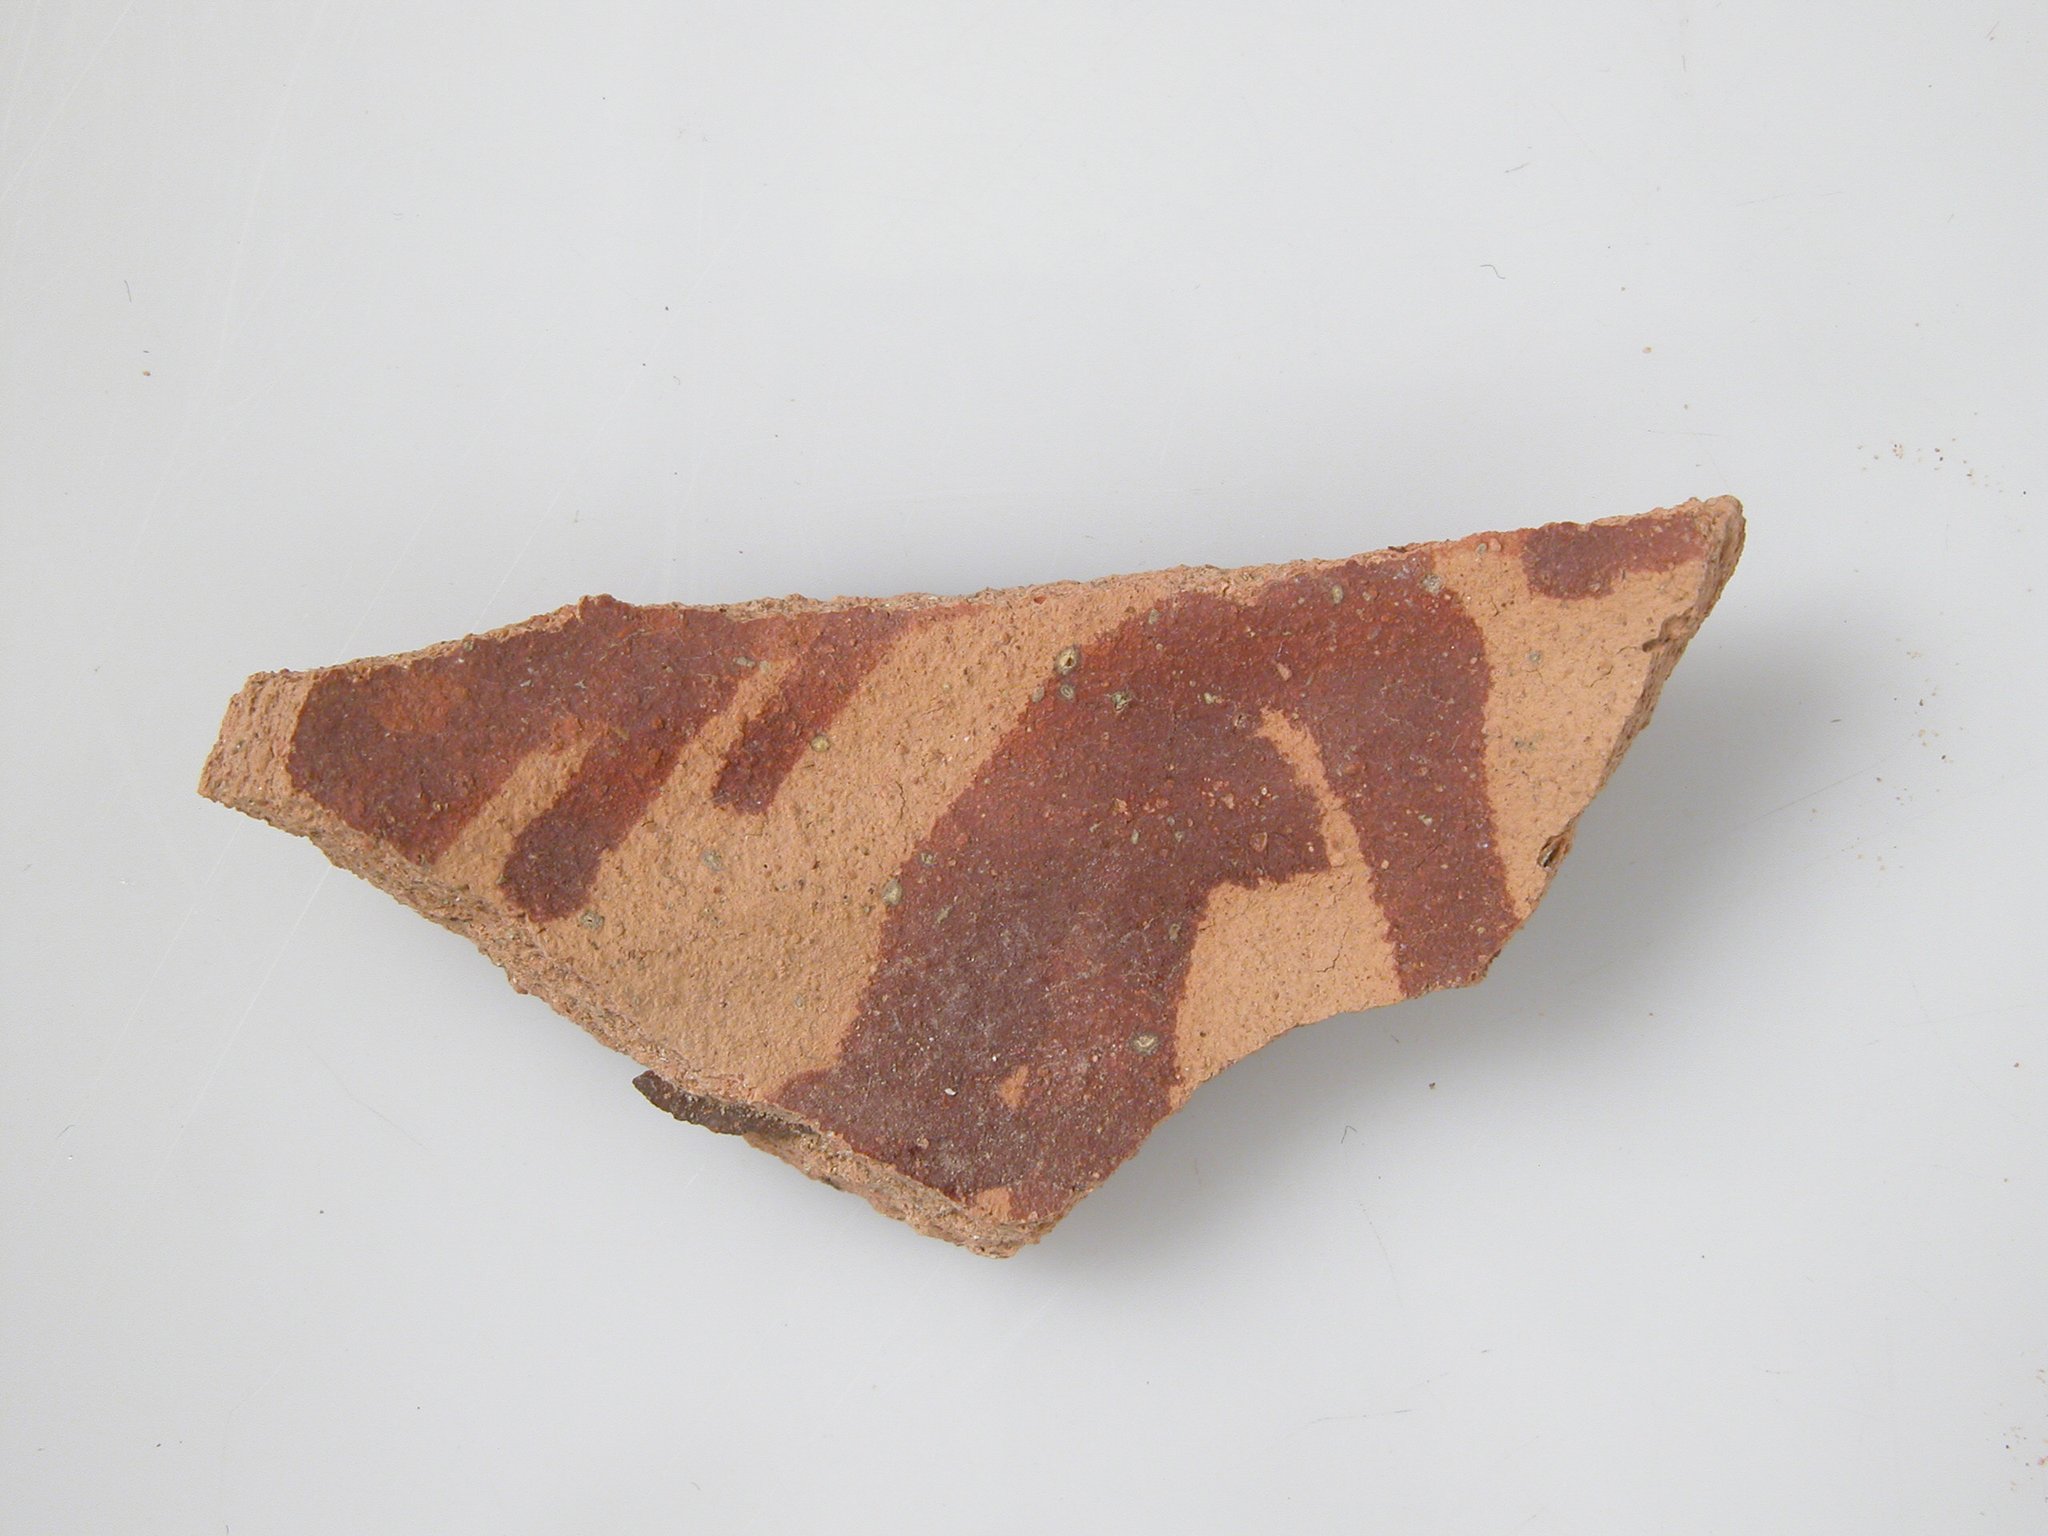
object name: fragment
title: Pottery Fragment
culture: coptic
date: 301-700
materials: earthenware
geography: egypt